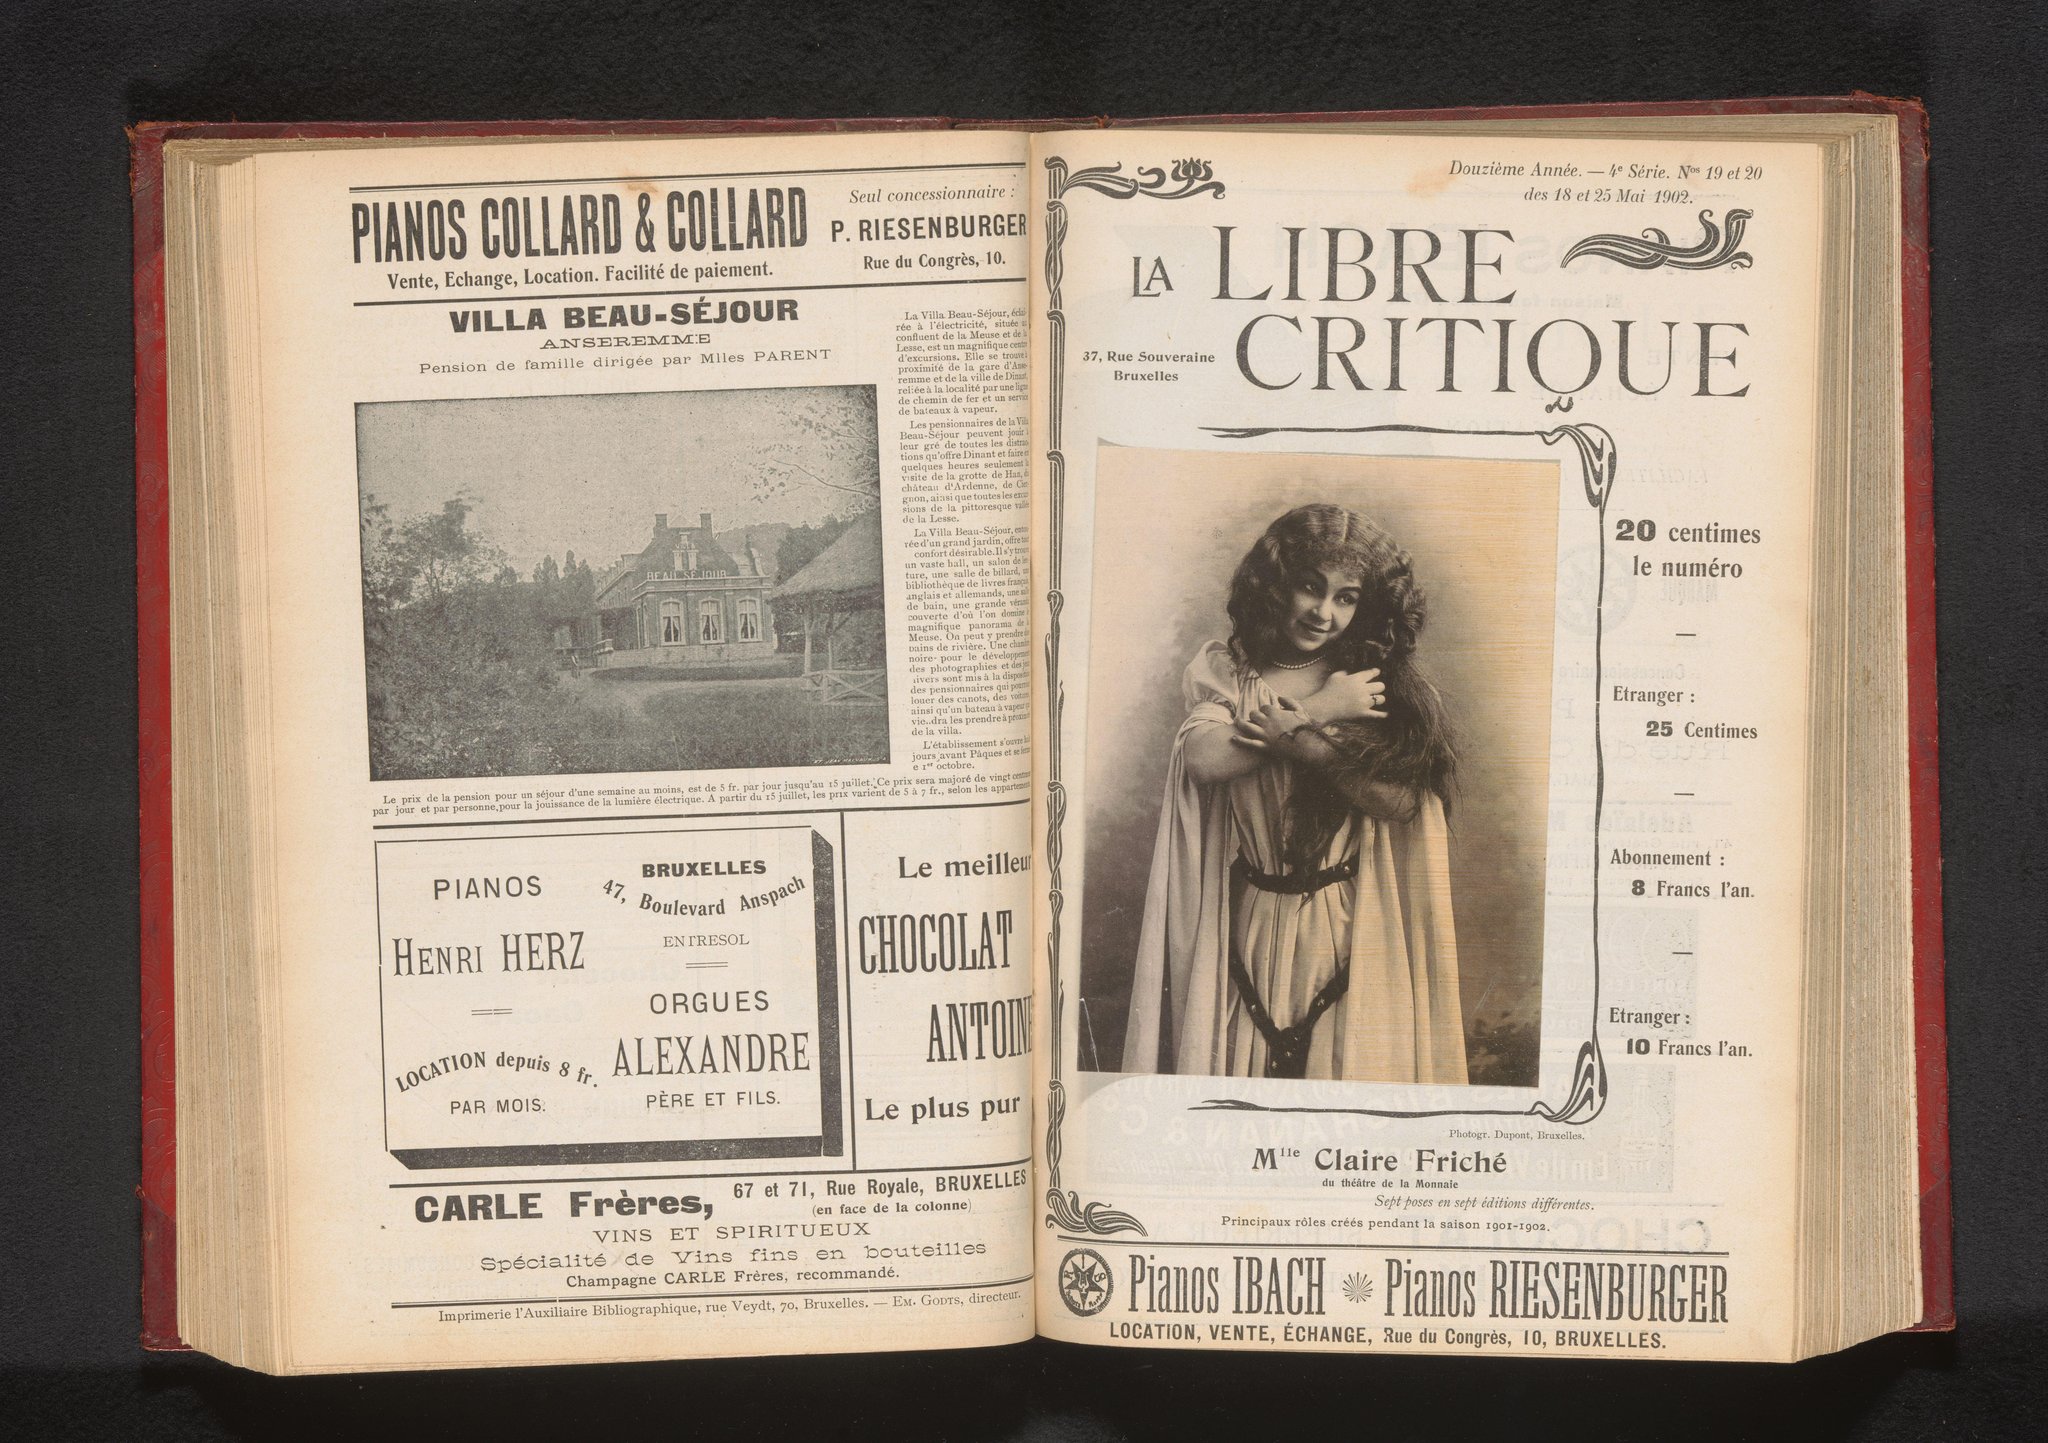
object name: page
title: Portret van Claire Friché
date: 1897-1902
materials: paper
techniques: photograph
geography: brussels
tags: opera-singer (female)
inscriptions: inscription: ‘du théâtre (...) la saison 1901-1902.’